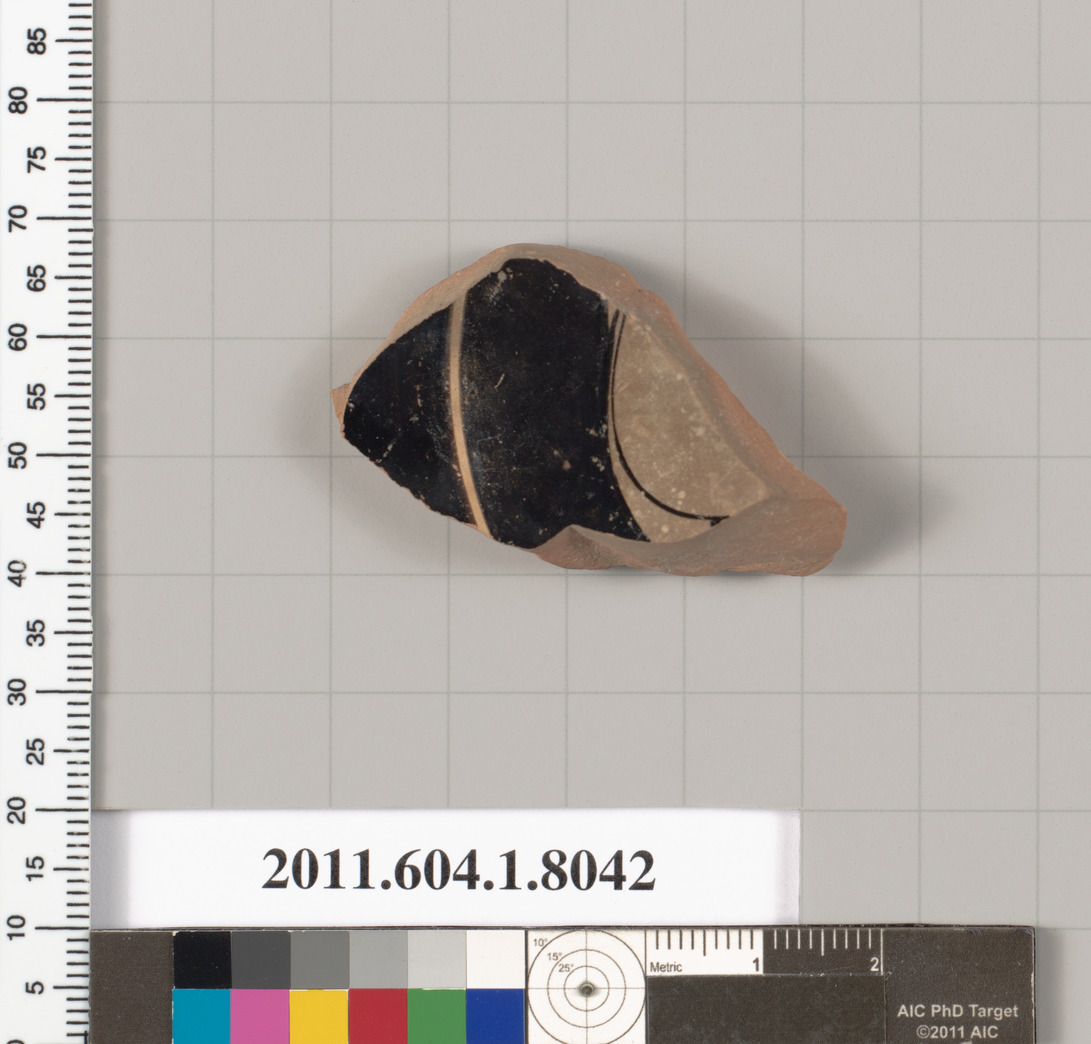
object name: kylix fragment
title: Terracotta fragment of a kylix (drinking cup)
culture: greek, attic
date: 510-500 BCE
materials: terracotta